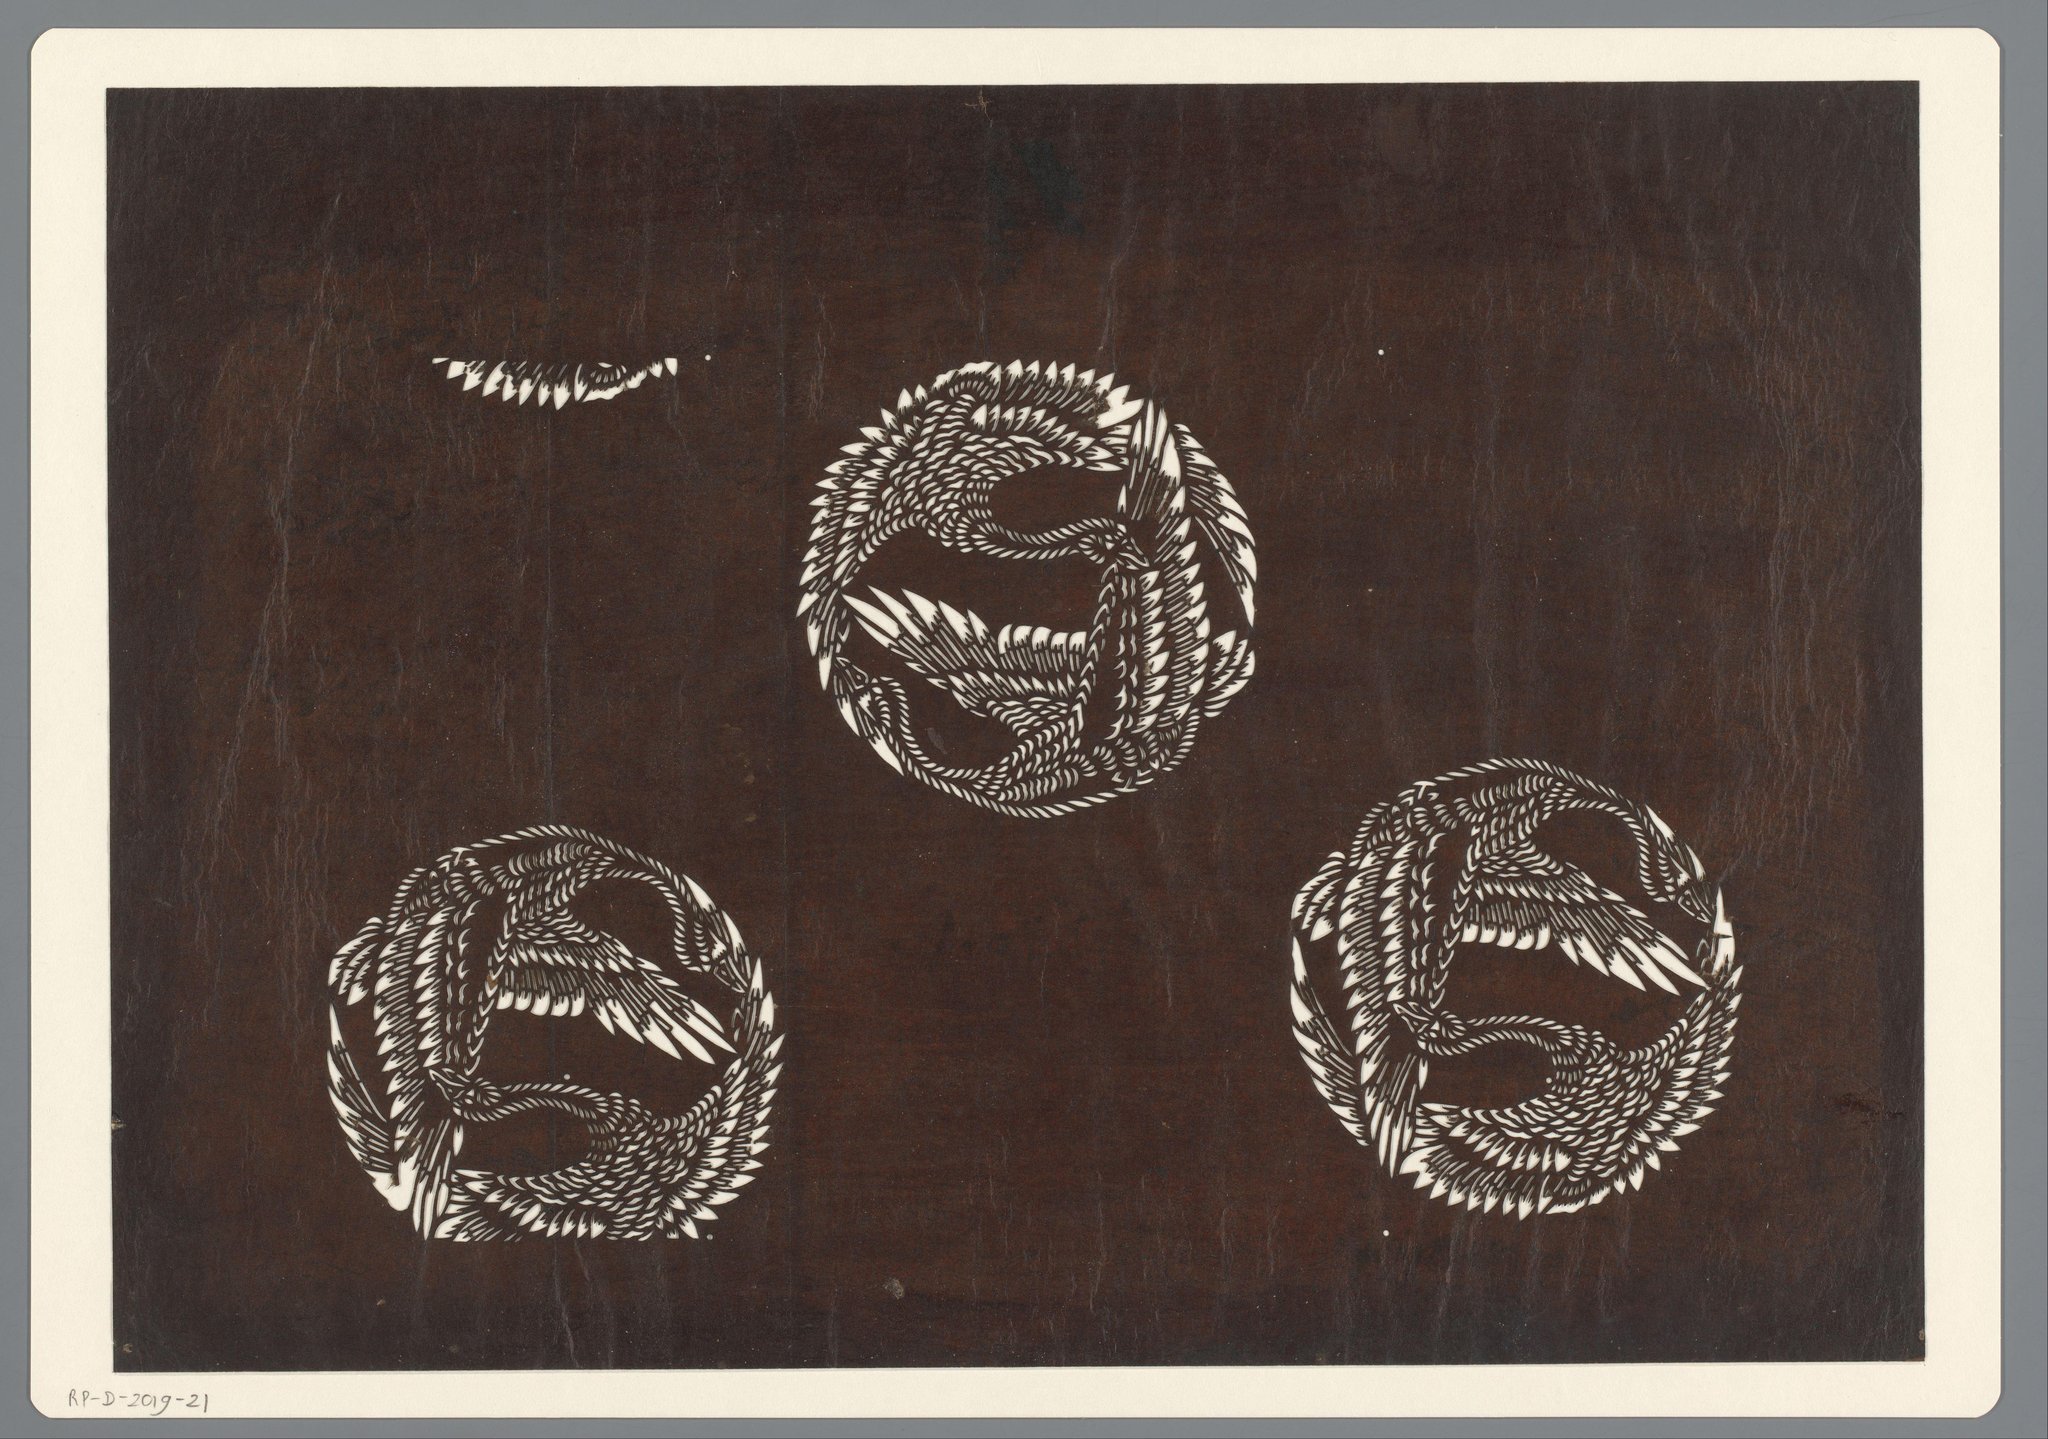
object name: katagami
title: Sjabloon met kraanvogels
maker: Anonymous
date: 1800-1909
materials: paper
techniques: cutting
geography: japan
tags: shore-birds and wading-birds: crane, ornament derived from animal forms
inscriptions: annotation: ‘Krani ... II se ...’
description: Japanse sjabloon (katagami) met een patroon van drie ronde emblemen met elk twee kraanvogels.